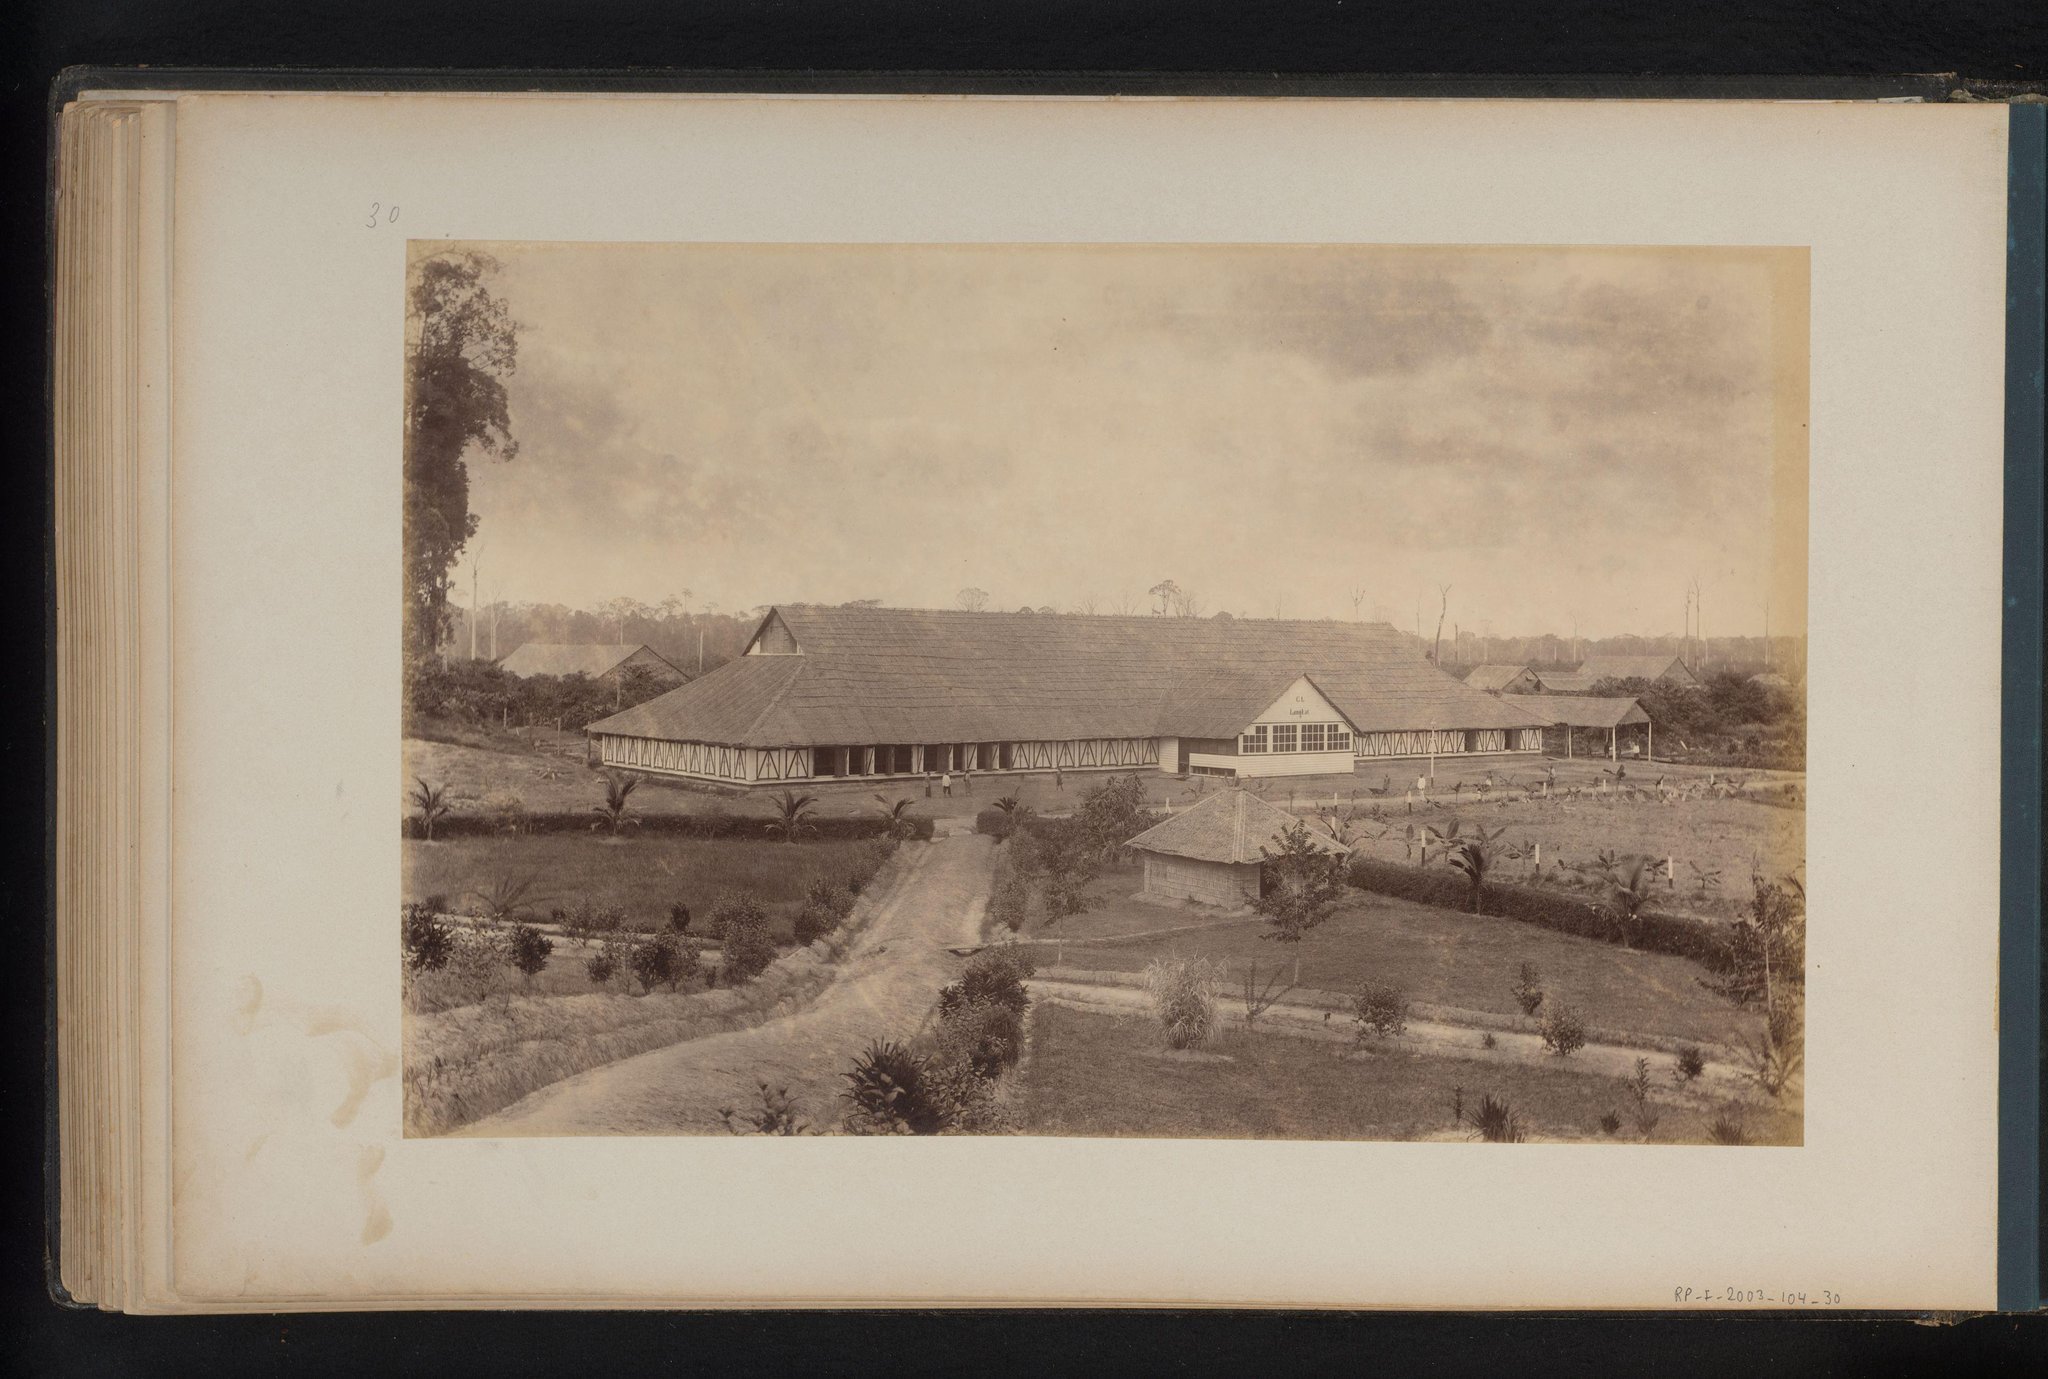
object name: album leaf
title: Gezicht op een fermenteerschuur voor tabak op de Stabat plantage in Langkat, Sumatra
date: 1890-1900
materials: cardboard, photographic support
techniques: albumen print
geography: sumatra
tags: plantation, shed, tobacco, sumatra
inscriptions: number: ‘30’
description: In de lijst van afbeeldingen wordt deze foto beschreven met de woorden "Fermentierscheune, Stabat-Estate".